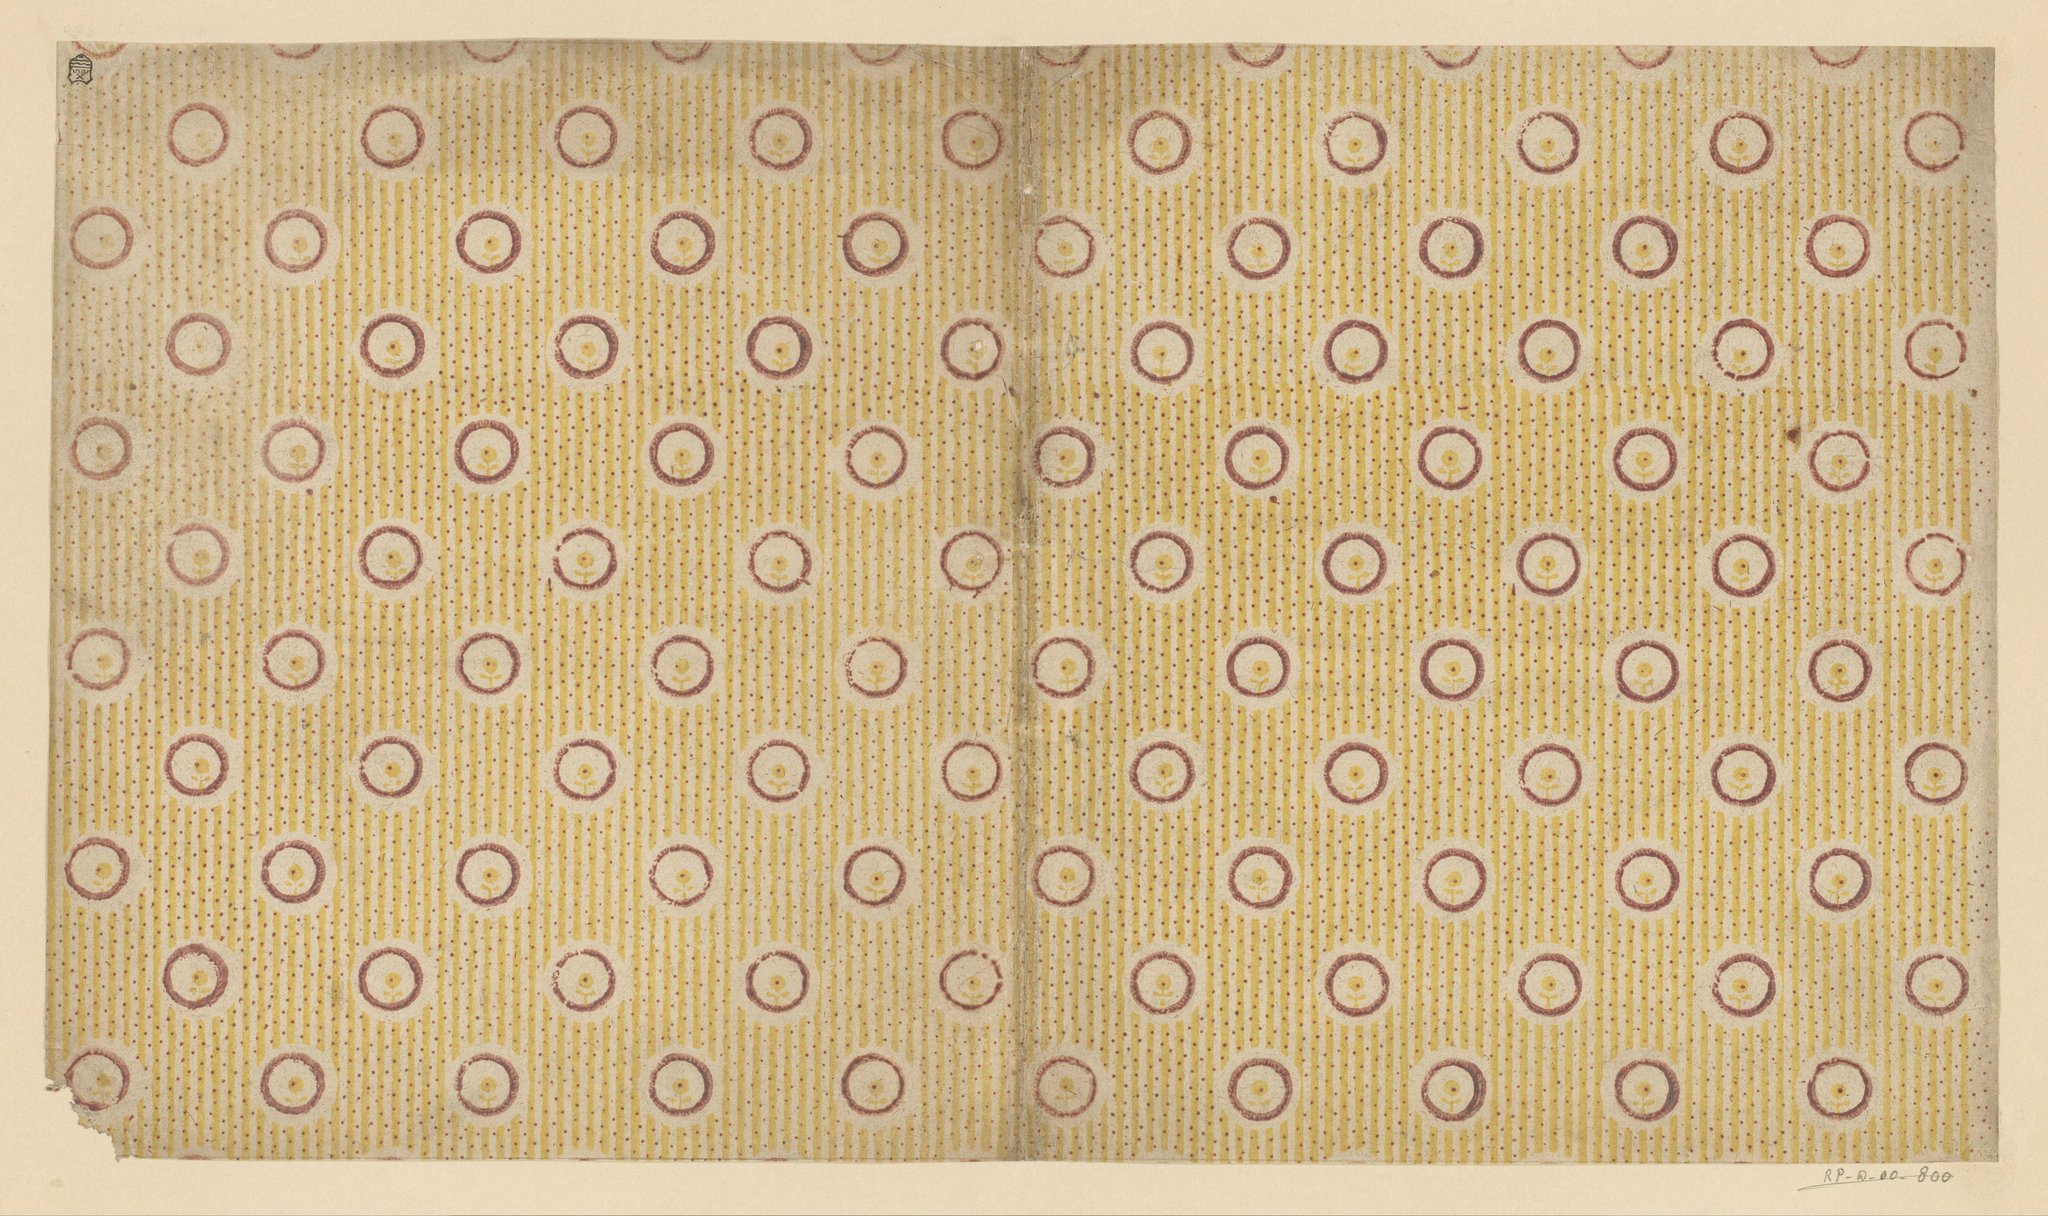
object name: wrapper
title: Blad met strooipatroon van cirkel in onderbroken lijnenfond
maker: Anonymous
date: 1750-1950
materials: paper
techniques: printing block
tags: ornament ~ geometric motifs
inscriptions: collector's mark: Lugt 2760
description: Blad met strooipatroon van cirkel met stip in onderbroken lijnenfond. Gebruikt als omslag.